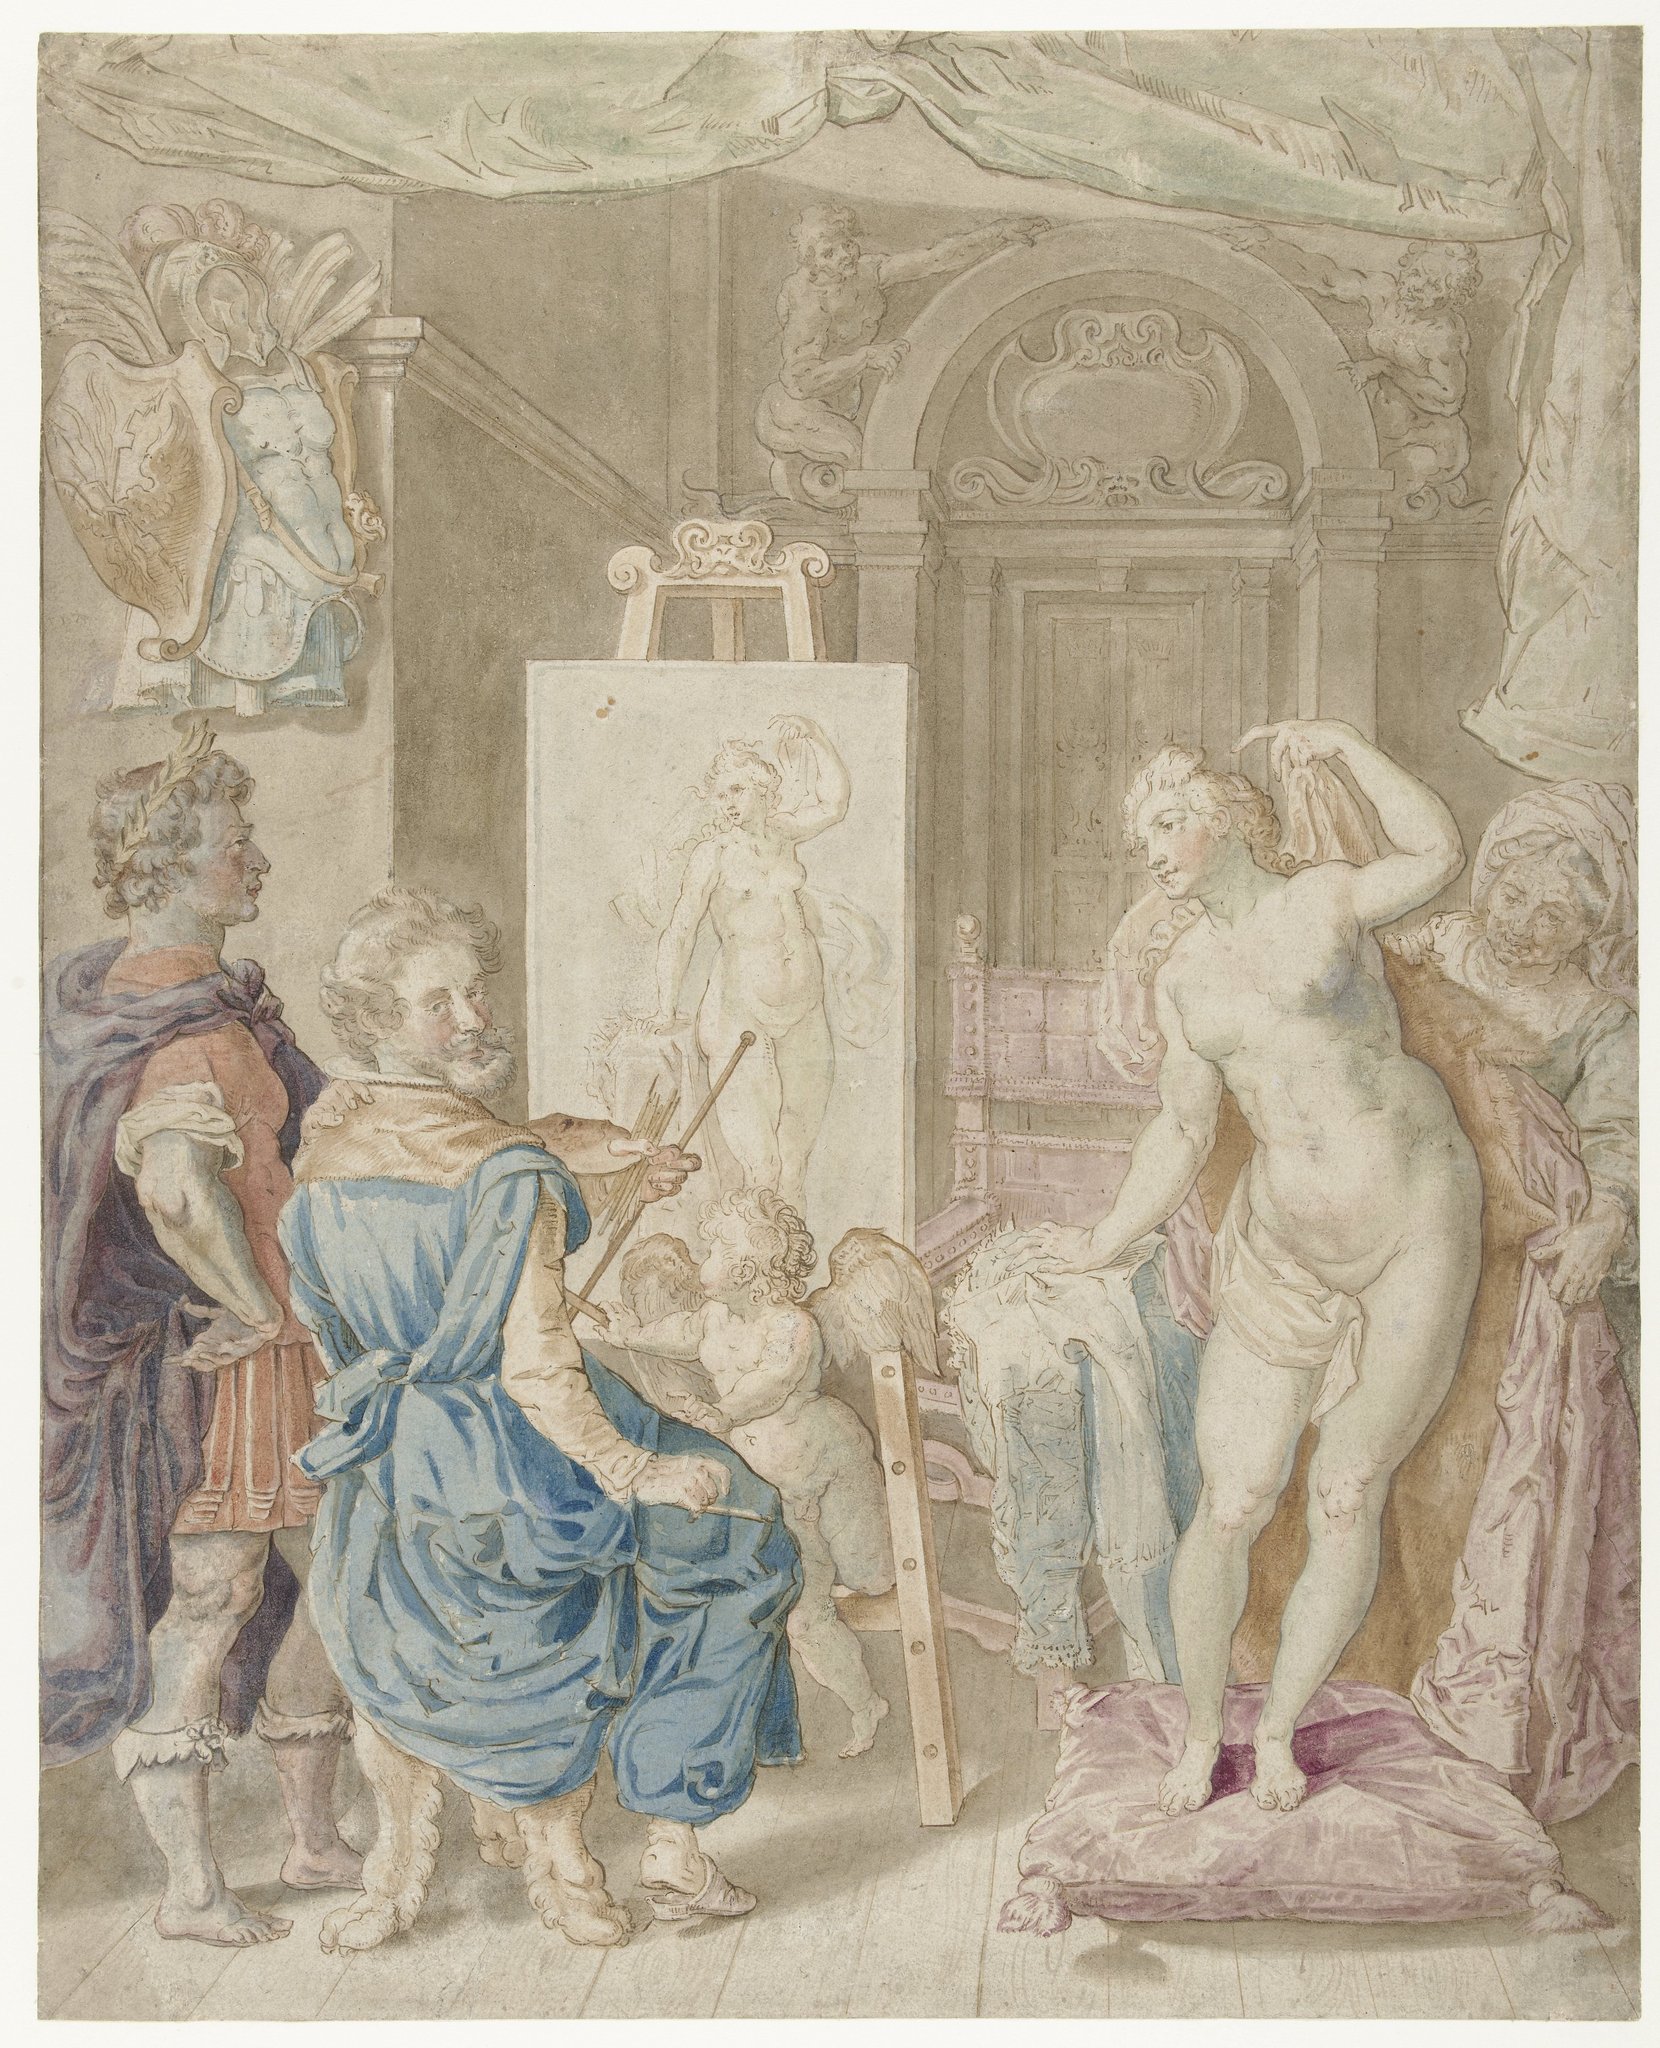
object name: drawing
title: Apelles schildert Campaspe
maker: pieter isaacsz.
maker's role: draughtsman, painter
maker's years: 1569-1625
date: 1579-1625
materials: ink, paper, watercolor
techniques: brush, pen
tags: apelles paints campaspe and falls in love with her; alexander yields her to him